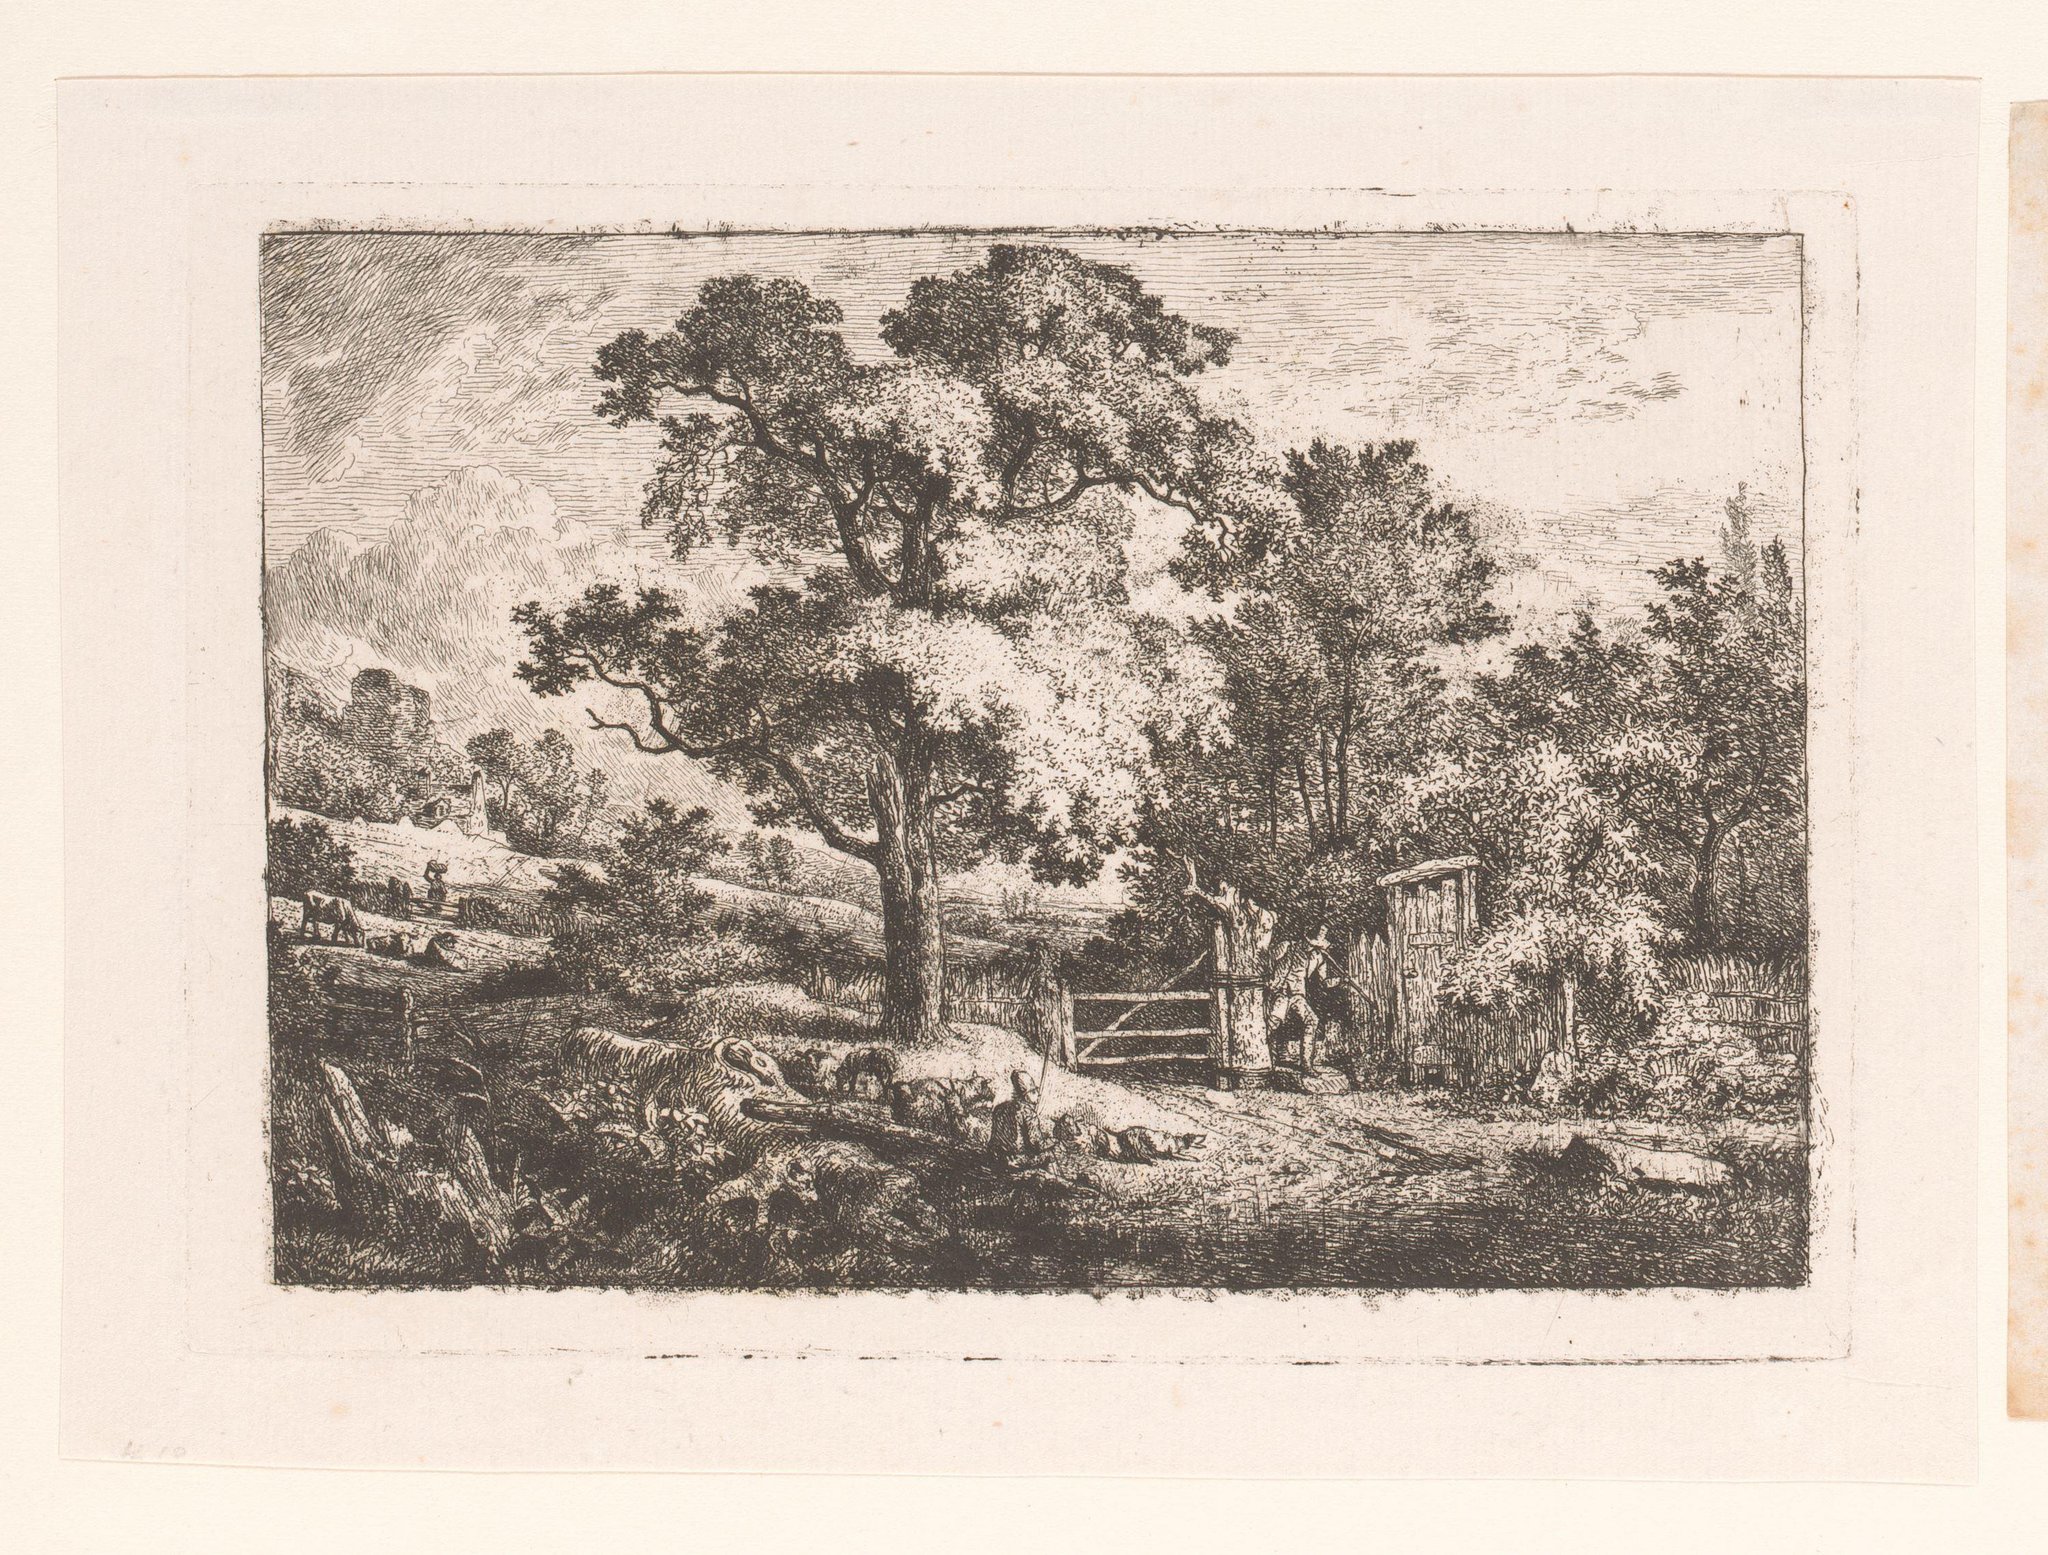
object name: print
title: Landschap met hekwerk en herders met vee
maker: jean louis demarne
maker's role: draughtsman, painter, print maker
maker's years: 1752-1829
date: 1762-1829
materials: paper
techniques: etching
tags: herding, herdsman, herdswoman, shepherd, shepherdess, cowherd, etc., fence, wall, paling, landscapes (+ landscape with figures, staffage), herd, flock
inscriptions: collector's mark: Lugt 2228